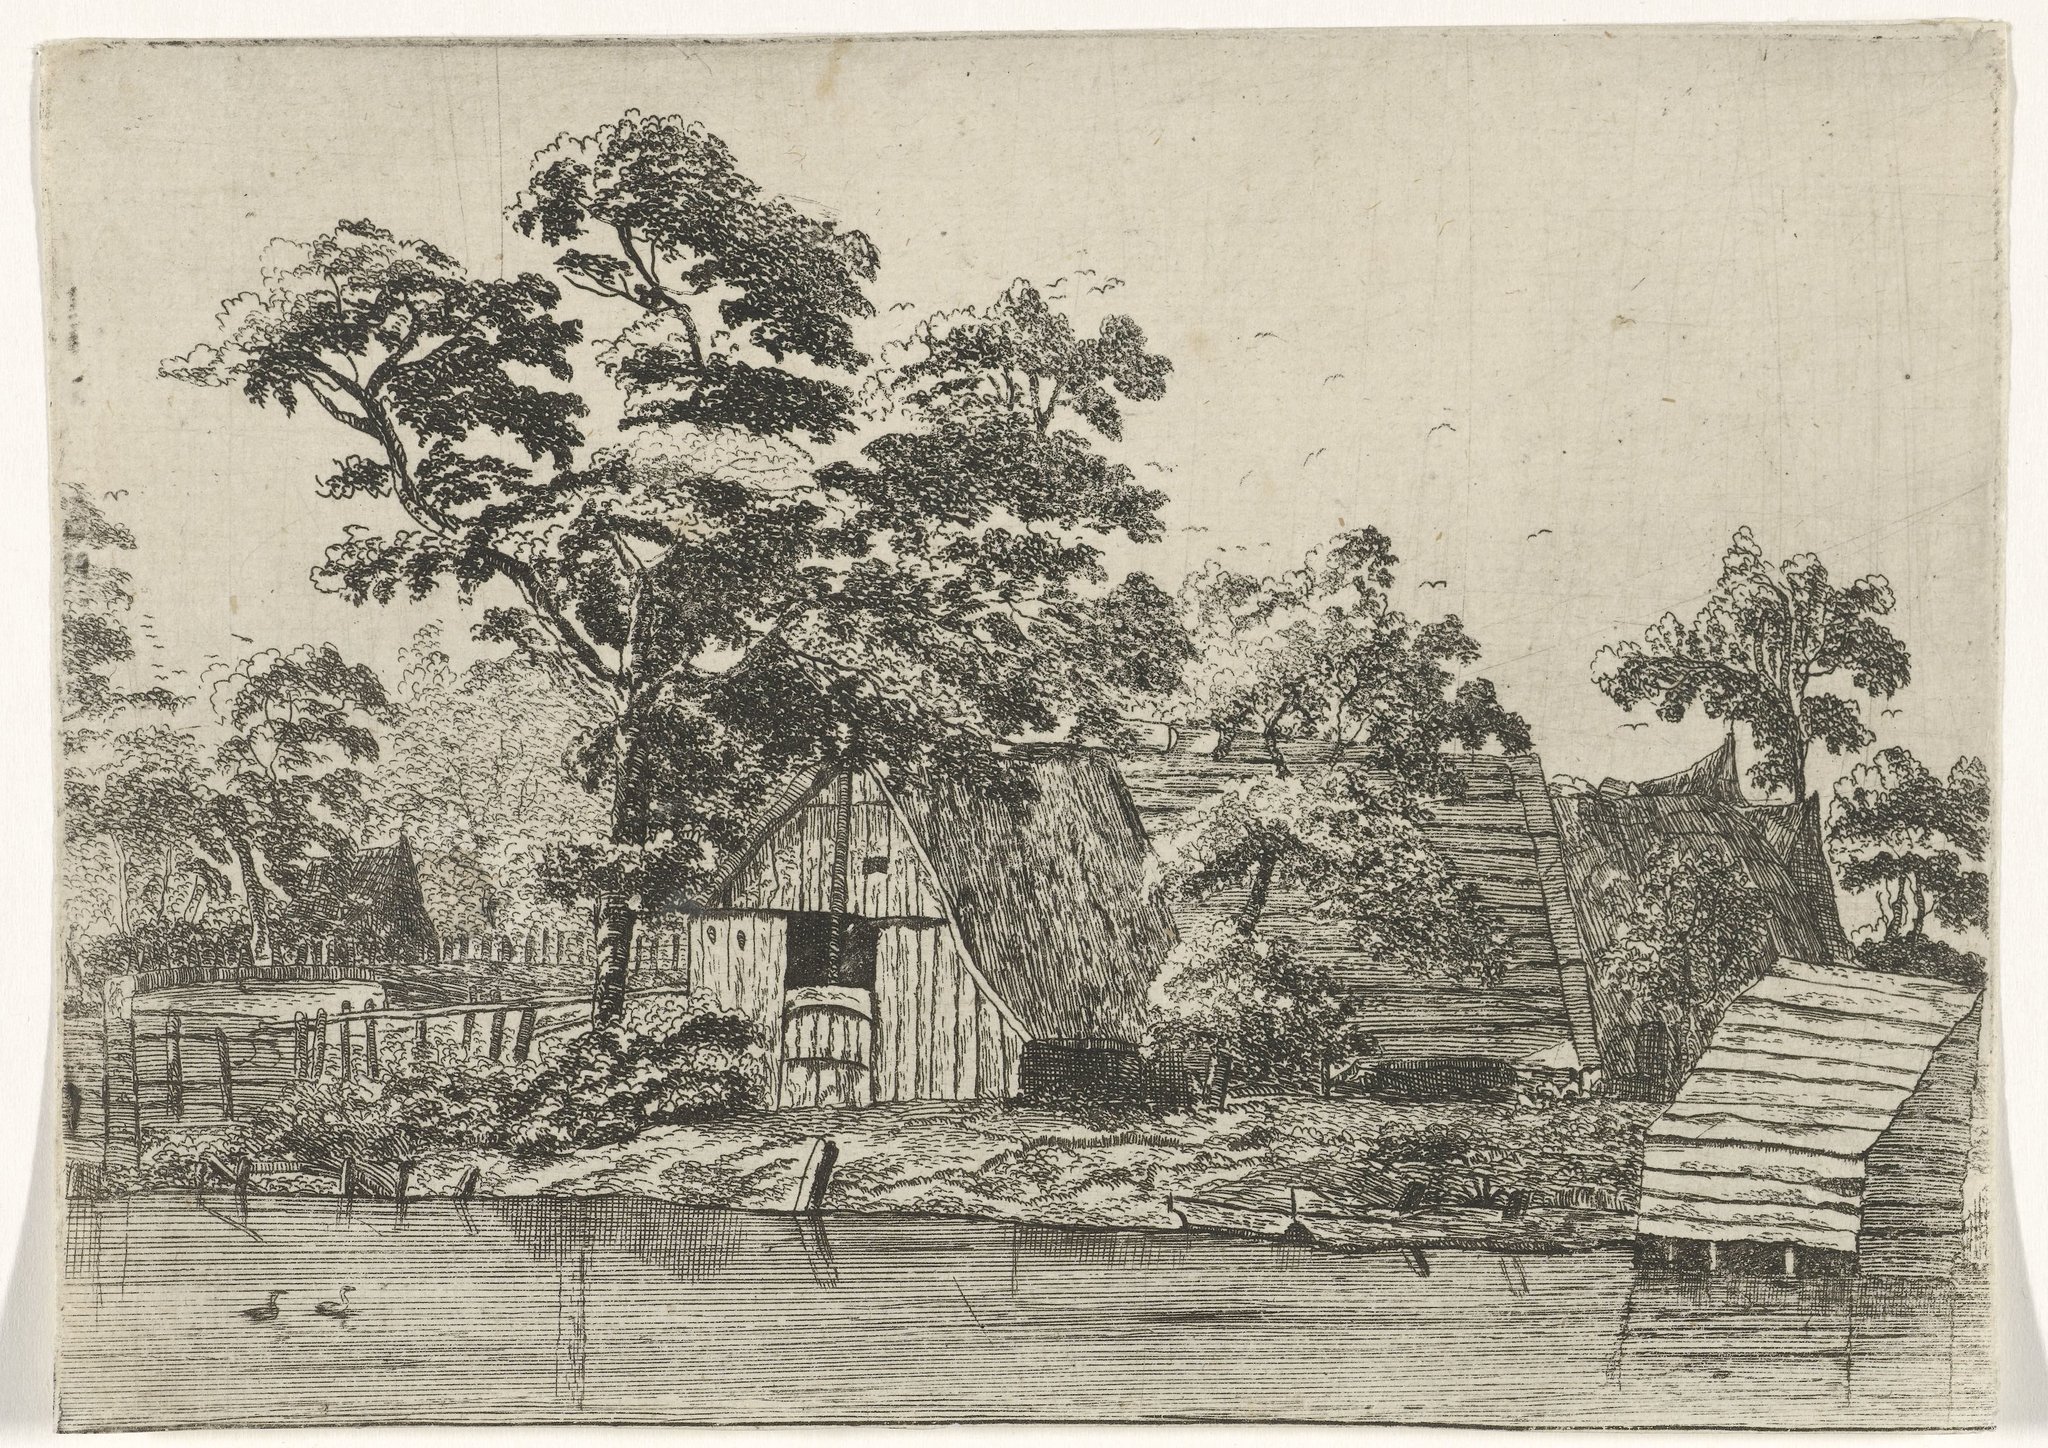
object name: print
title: Huizen aan een vijver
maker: anna maria de koker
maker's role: print maker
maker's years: -1698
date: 1640-1698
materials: paper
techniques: etching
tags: trees, cottage, pond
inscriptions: collector's mark: Lugt 2228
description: Aan een vijver, waar twee eenden zwemmen, ligt een houten huis met rechts daarvan in het water een schuurtje. Op de achtergrond is een aantal huizen tussen het geboomte te zien en in de lucht vliegen vogels.